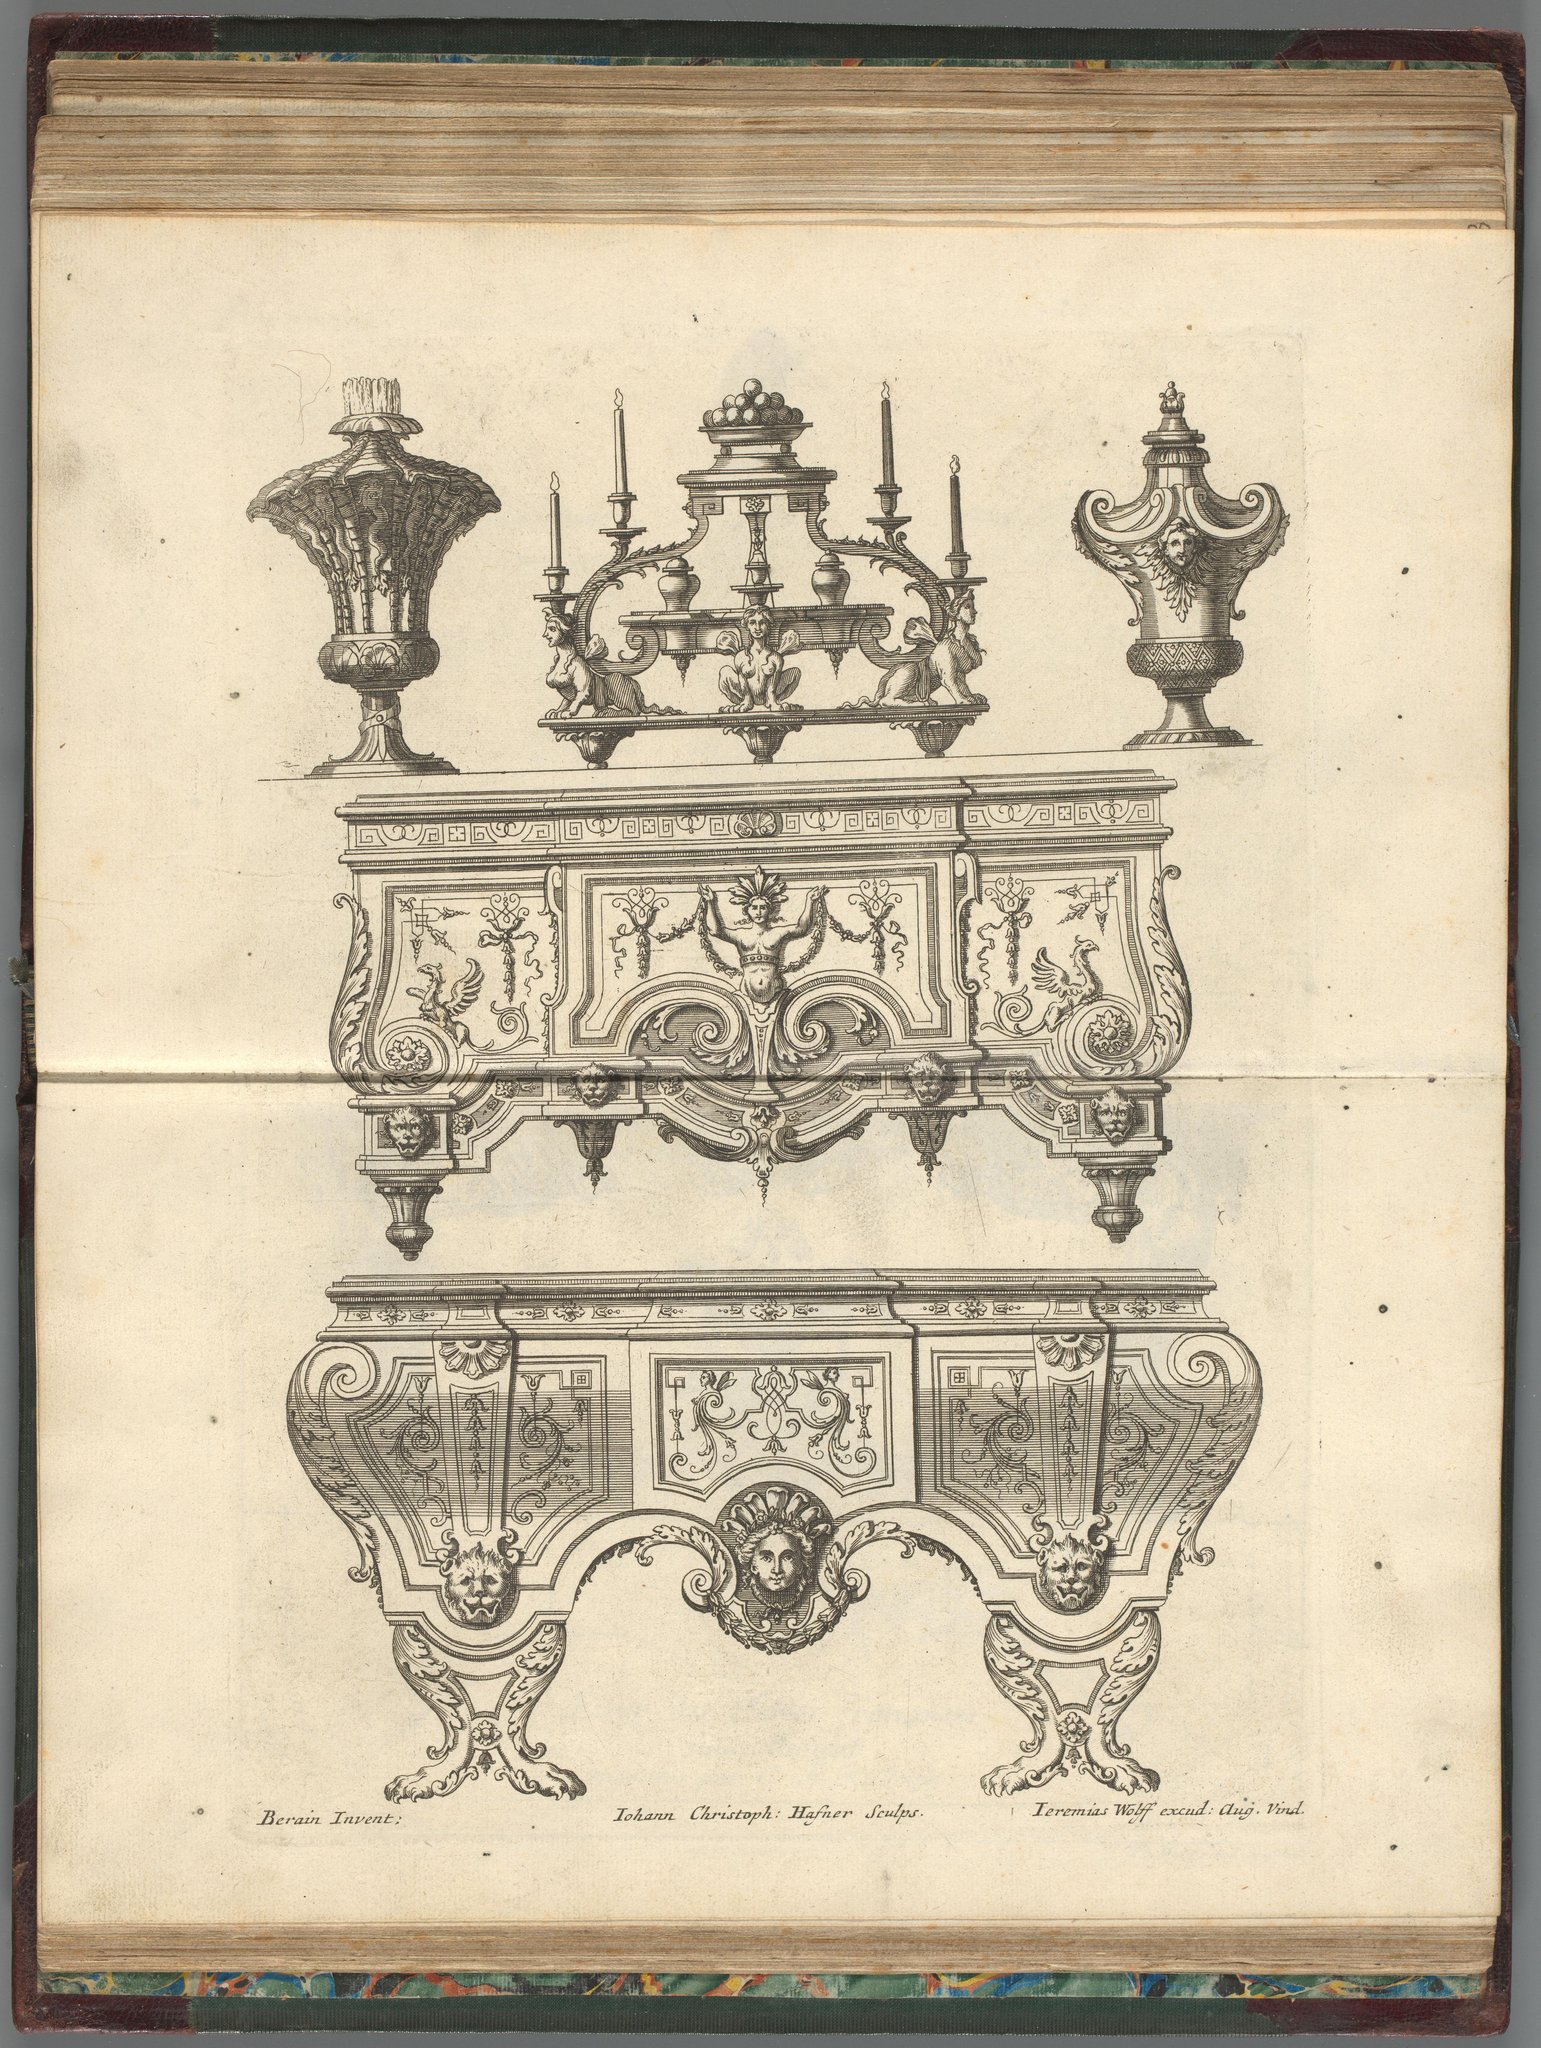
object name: album leaf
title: Ontwerpen van twee bureaus met inlegwerk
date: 1686-1724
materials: paper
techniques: etching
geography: augsburg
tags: writing-table, writing-desk, ornaments ~ art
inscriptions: signature: ‘Ieremias Wolff excud Aug. Vind.’, signature: ‘Berain Invent.’, signature: ‘Iohann Christoph Hafner Sculps.’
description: Ontwerpen van twee bureaus met inlegwerk boven elkaar. Op het bovenste bureau staat serviesgoed en vazen. Prent maakt deel uit van een album. Hoogstwaarschijnlijk gespiegelde kopie naar Frans origineel.